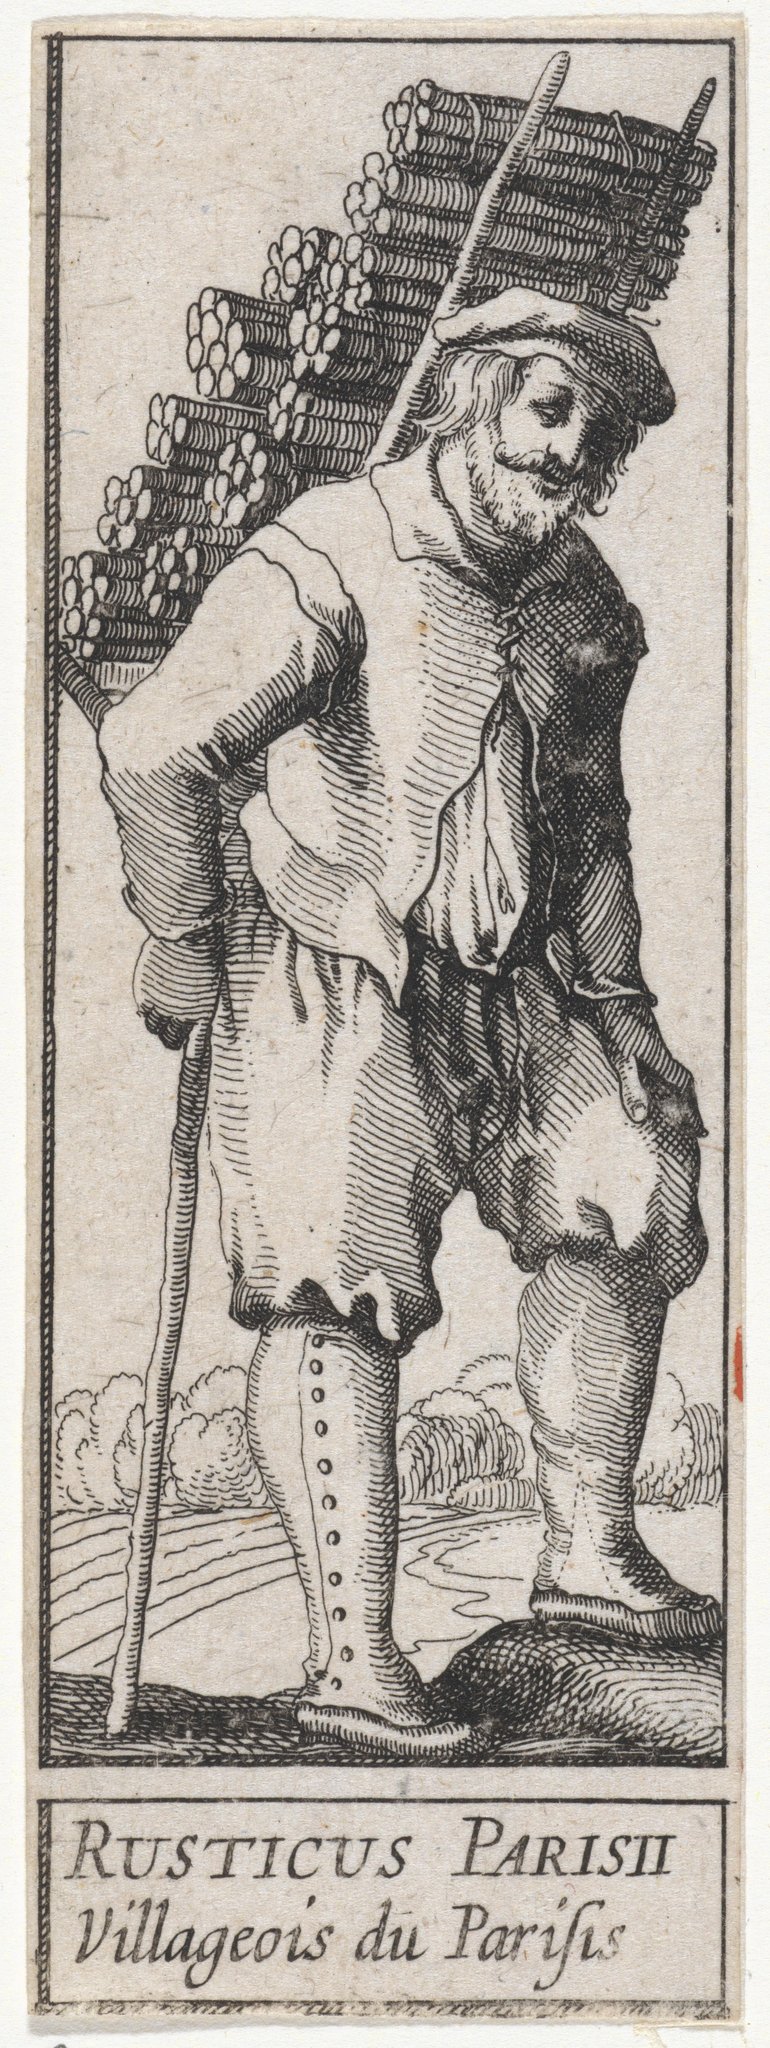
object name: costume print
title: RUSTICUS PARISII / Villageois de Parisis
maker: claes jansz. visscher (ii)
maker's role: draughtsman, print maker, publisher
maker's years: 1586-1652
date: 1618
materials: paper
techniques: etching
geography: amsterdam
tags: farmers, europeans (with name), clothes, costume (+ men's clothes)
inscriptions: caption: ‘RUSTICUS PARISII / Villageois de Parisis’, collector's mark: Lugt 240, collector's mark: Lugt 1838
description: Een landman, eenvoudig gekleed, met draagbaar met hout op zijn rug, naar rechts. Onderdeel van rand om kaart met Parijs in vogelvlucht, van twee platen. In de rand links en rechts kostuumprentjes met de vier rangen en standen. Links kostuumprentjes met herenkostuums; rechts de dameskostuums. Kostuumprentjes vrij naar Mattheus Merian. (German Hollst. 459) In RPK de kostuumprentjes los aanwezig.